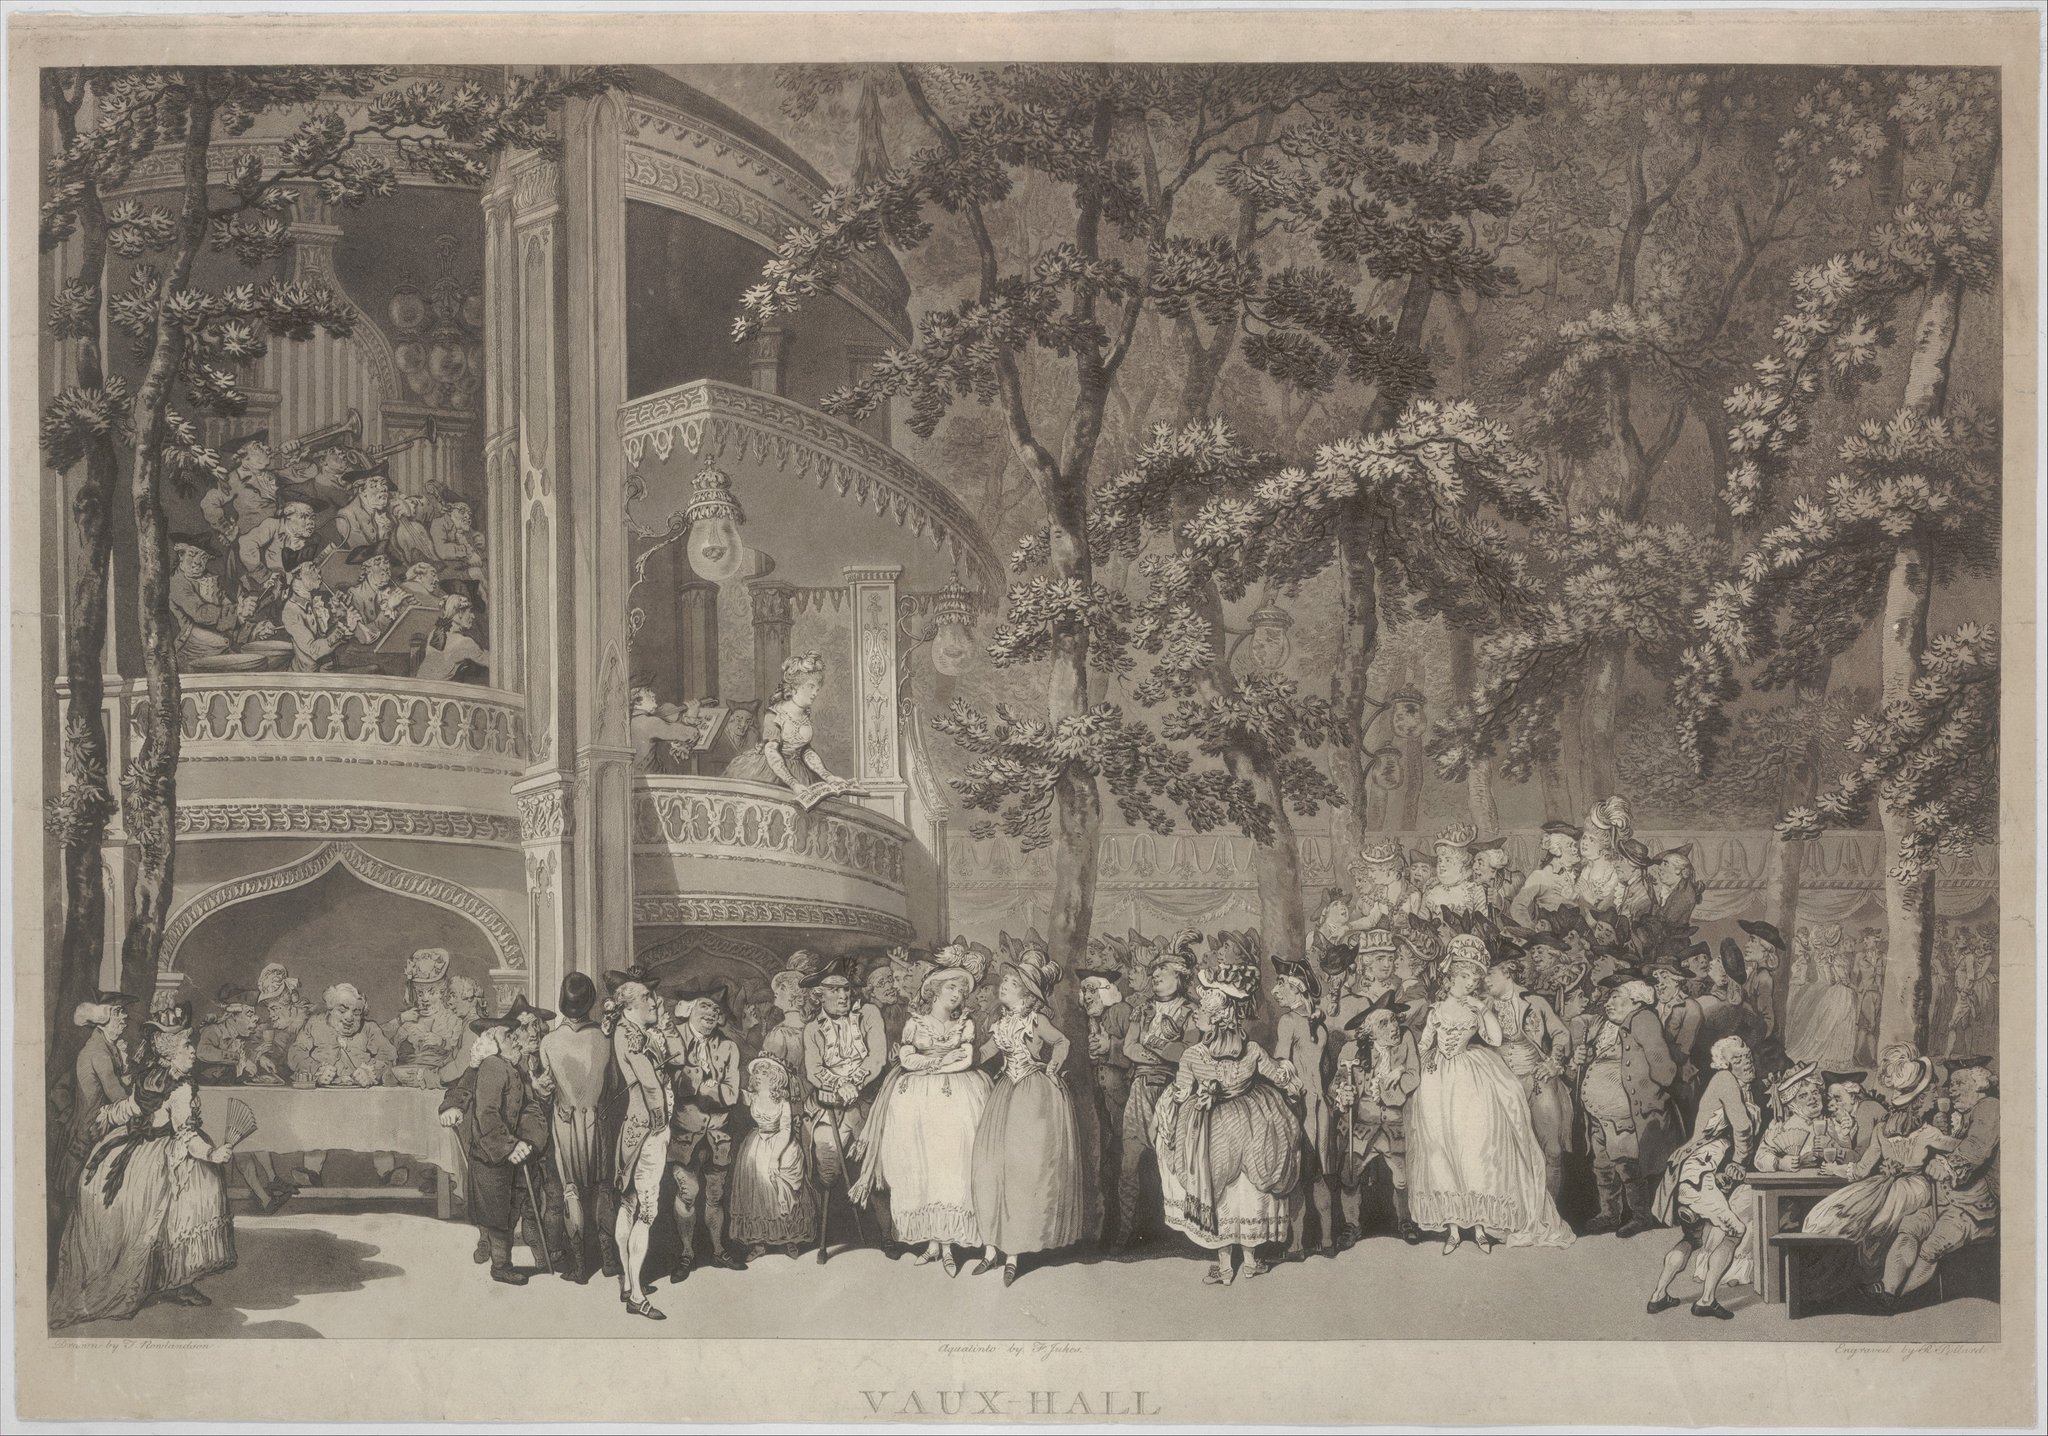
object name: print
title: Vaux-hall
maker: thomas rowlandson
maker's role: artist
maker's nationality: british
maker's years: 1757-1827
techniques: aquatint, engraving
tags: performance,satire,men,women,singing,musicians